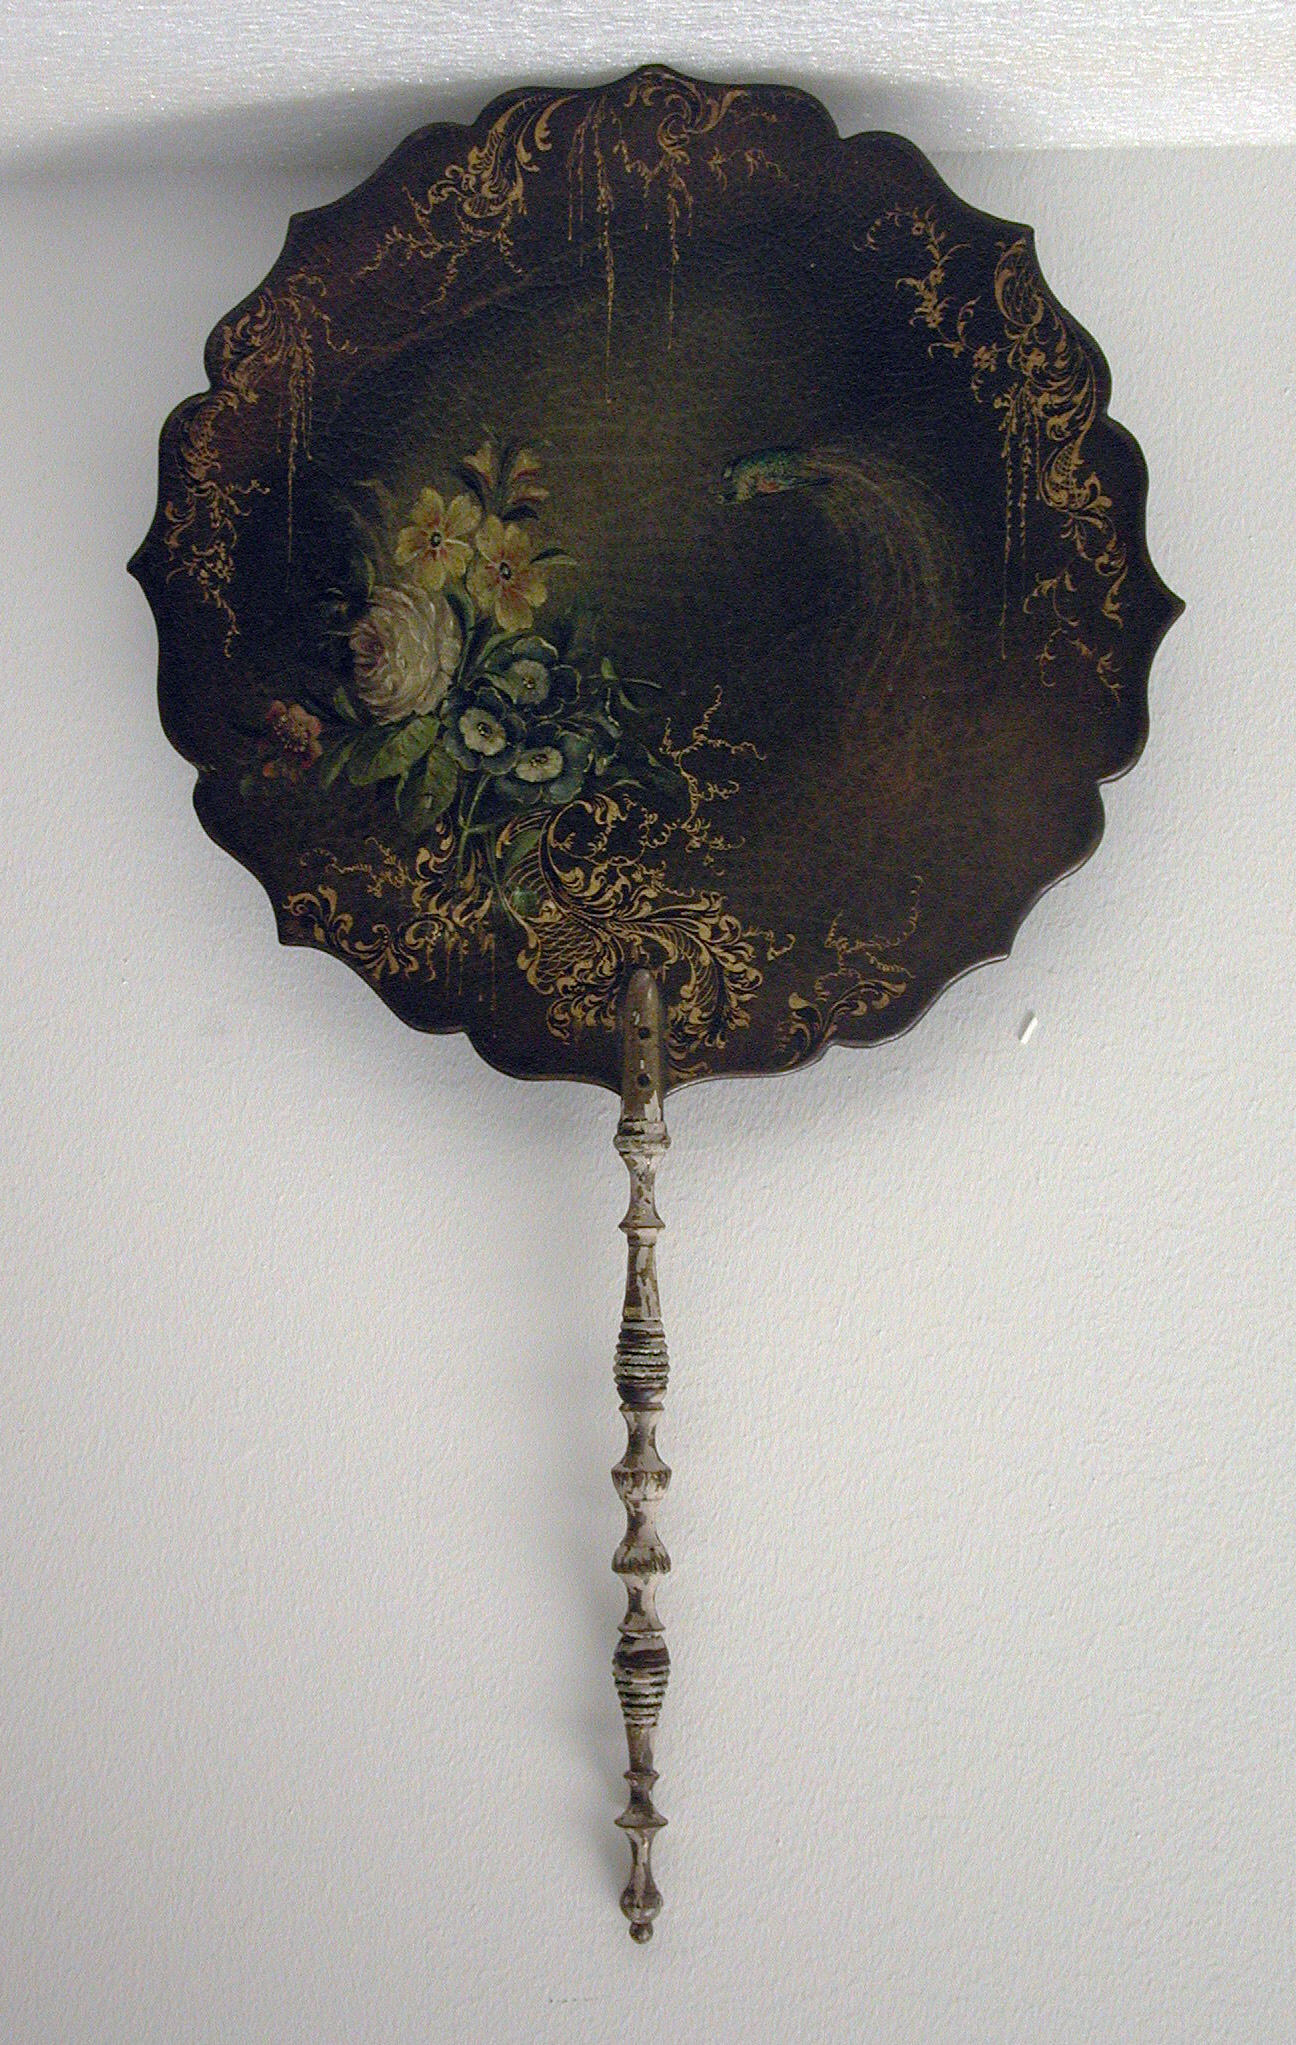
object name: handscreen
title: Handscreen (one of a pair)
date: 1834-1866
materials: gilt, paper, wood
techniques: gilding, lacquer, painting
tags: birds,flowers